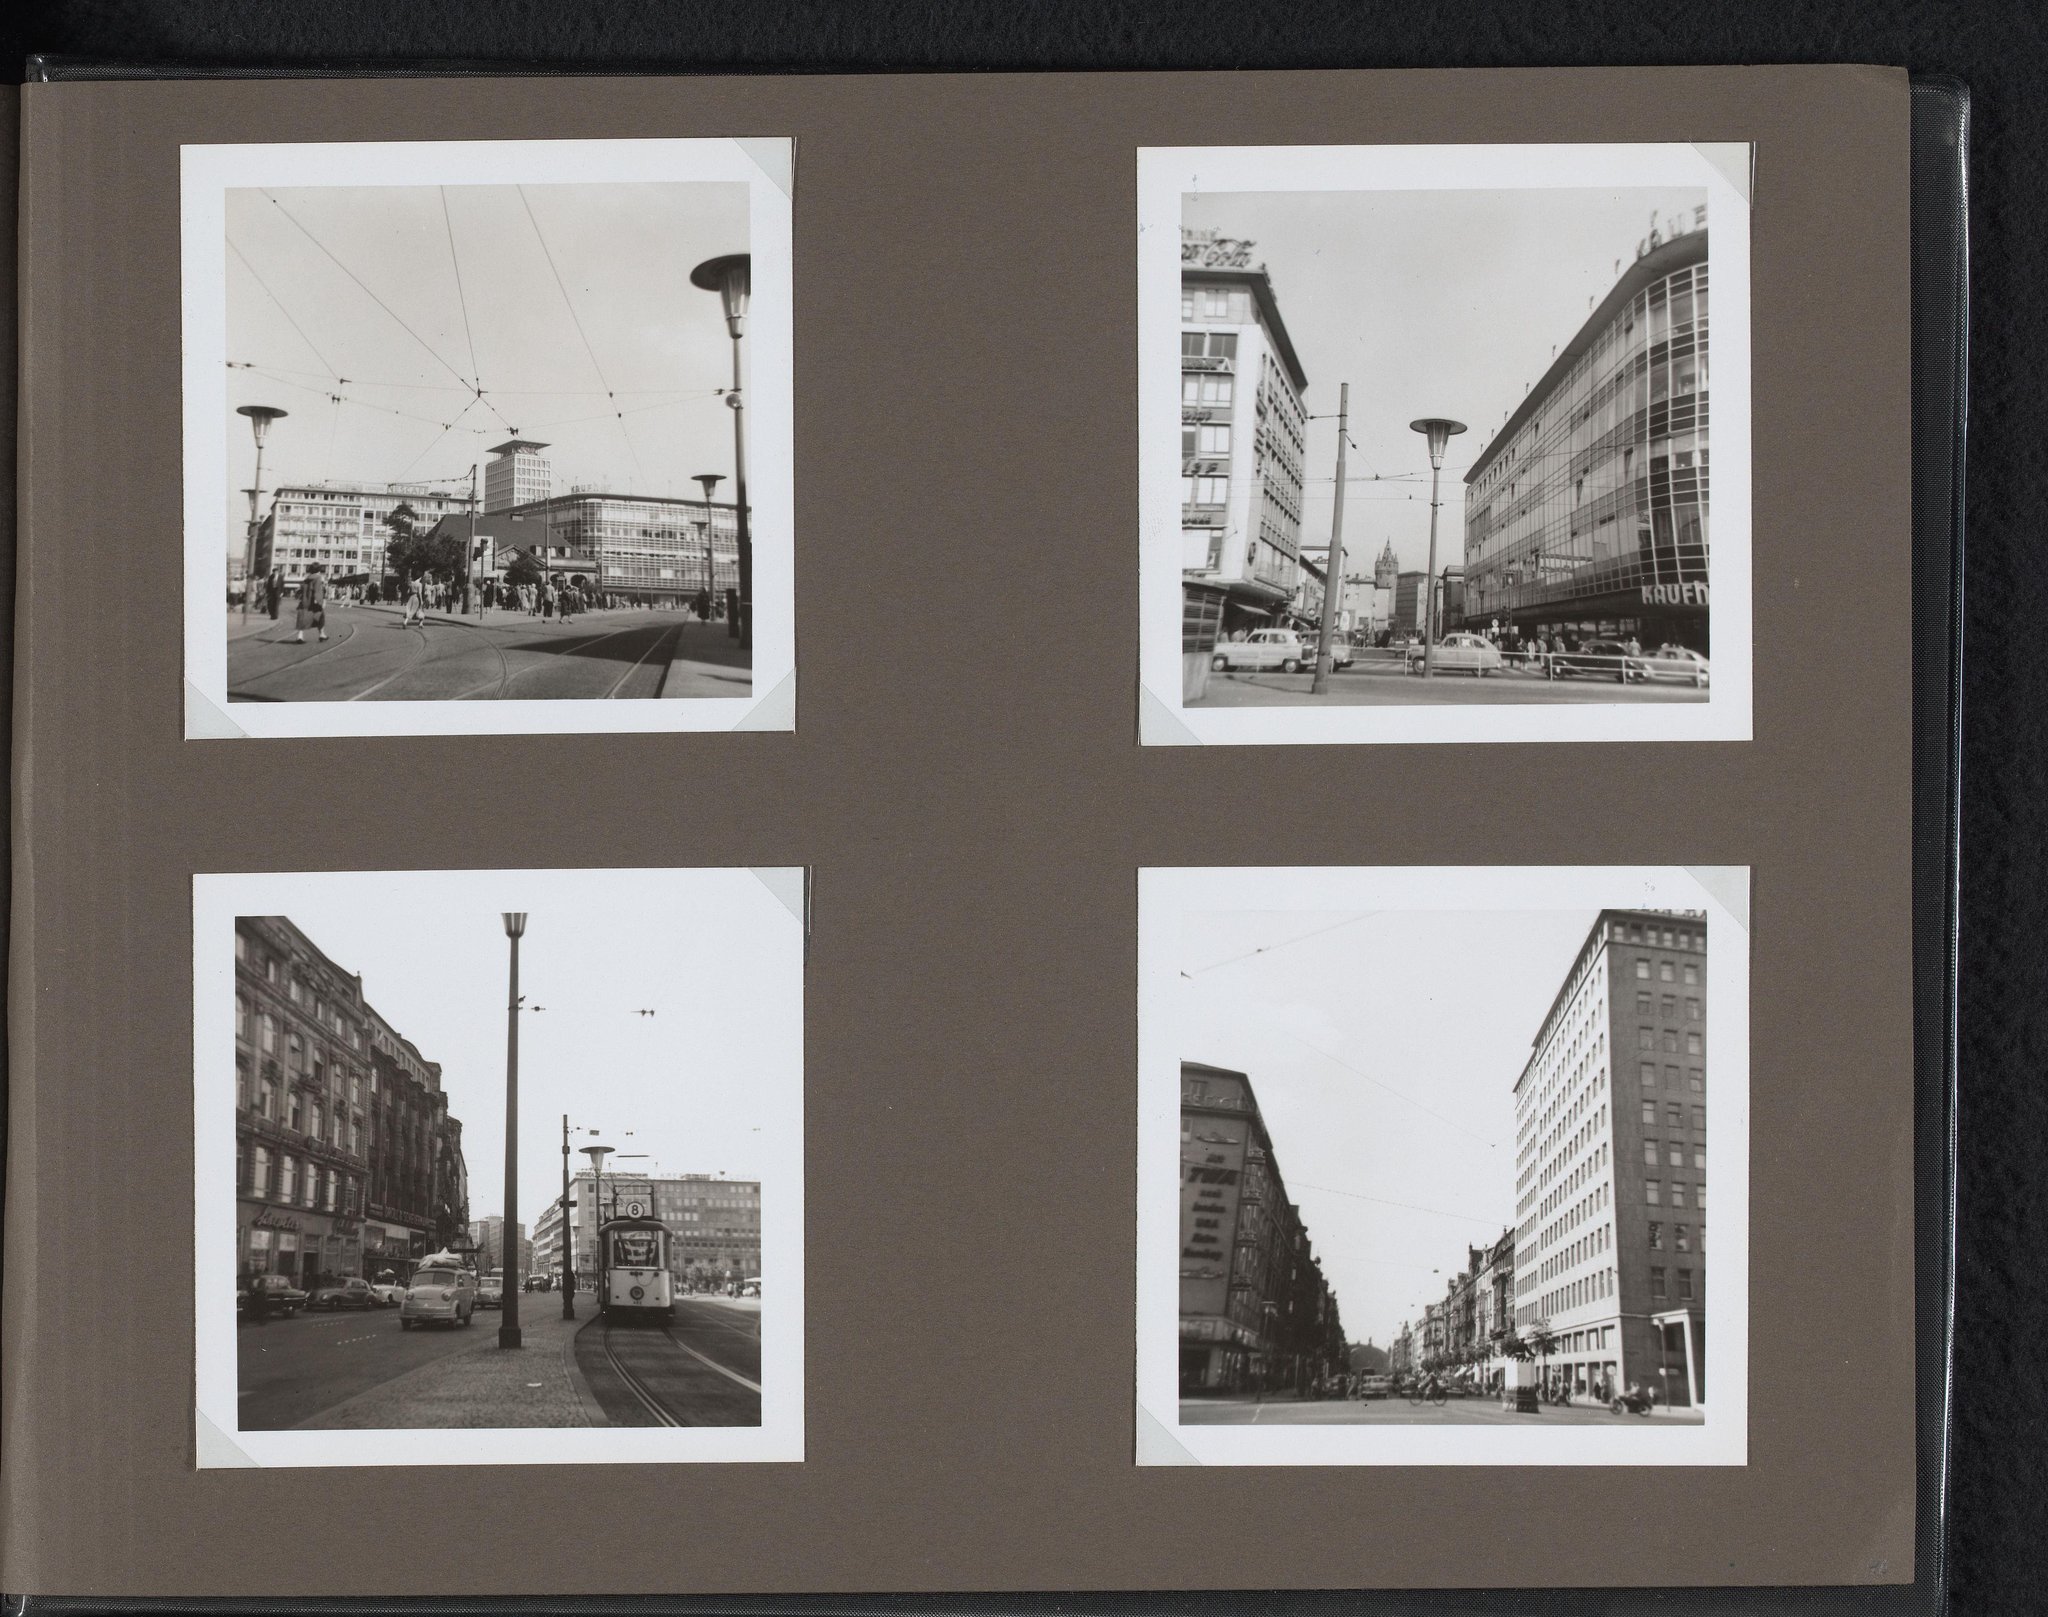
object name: photograph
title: Straatgezichten in Wenen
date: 1955-1970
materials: paper, cardboard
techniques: gelatin silver print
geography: vienna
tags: tram, automobile, street, vienna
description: Blad bevat vier foto's. Zonder personen gerelateerd aan de familie Wachenheimer. Deze foto's maken deel uit van een album.